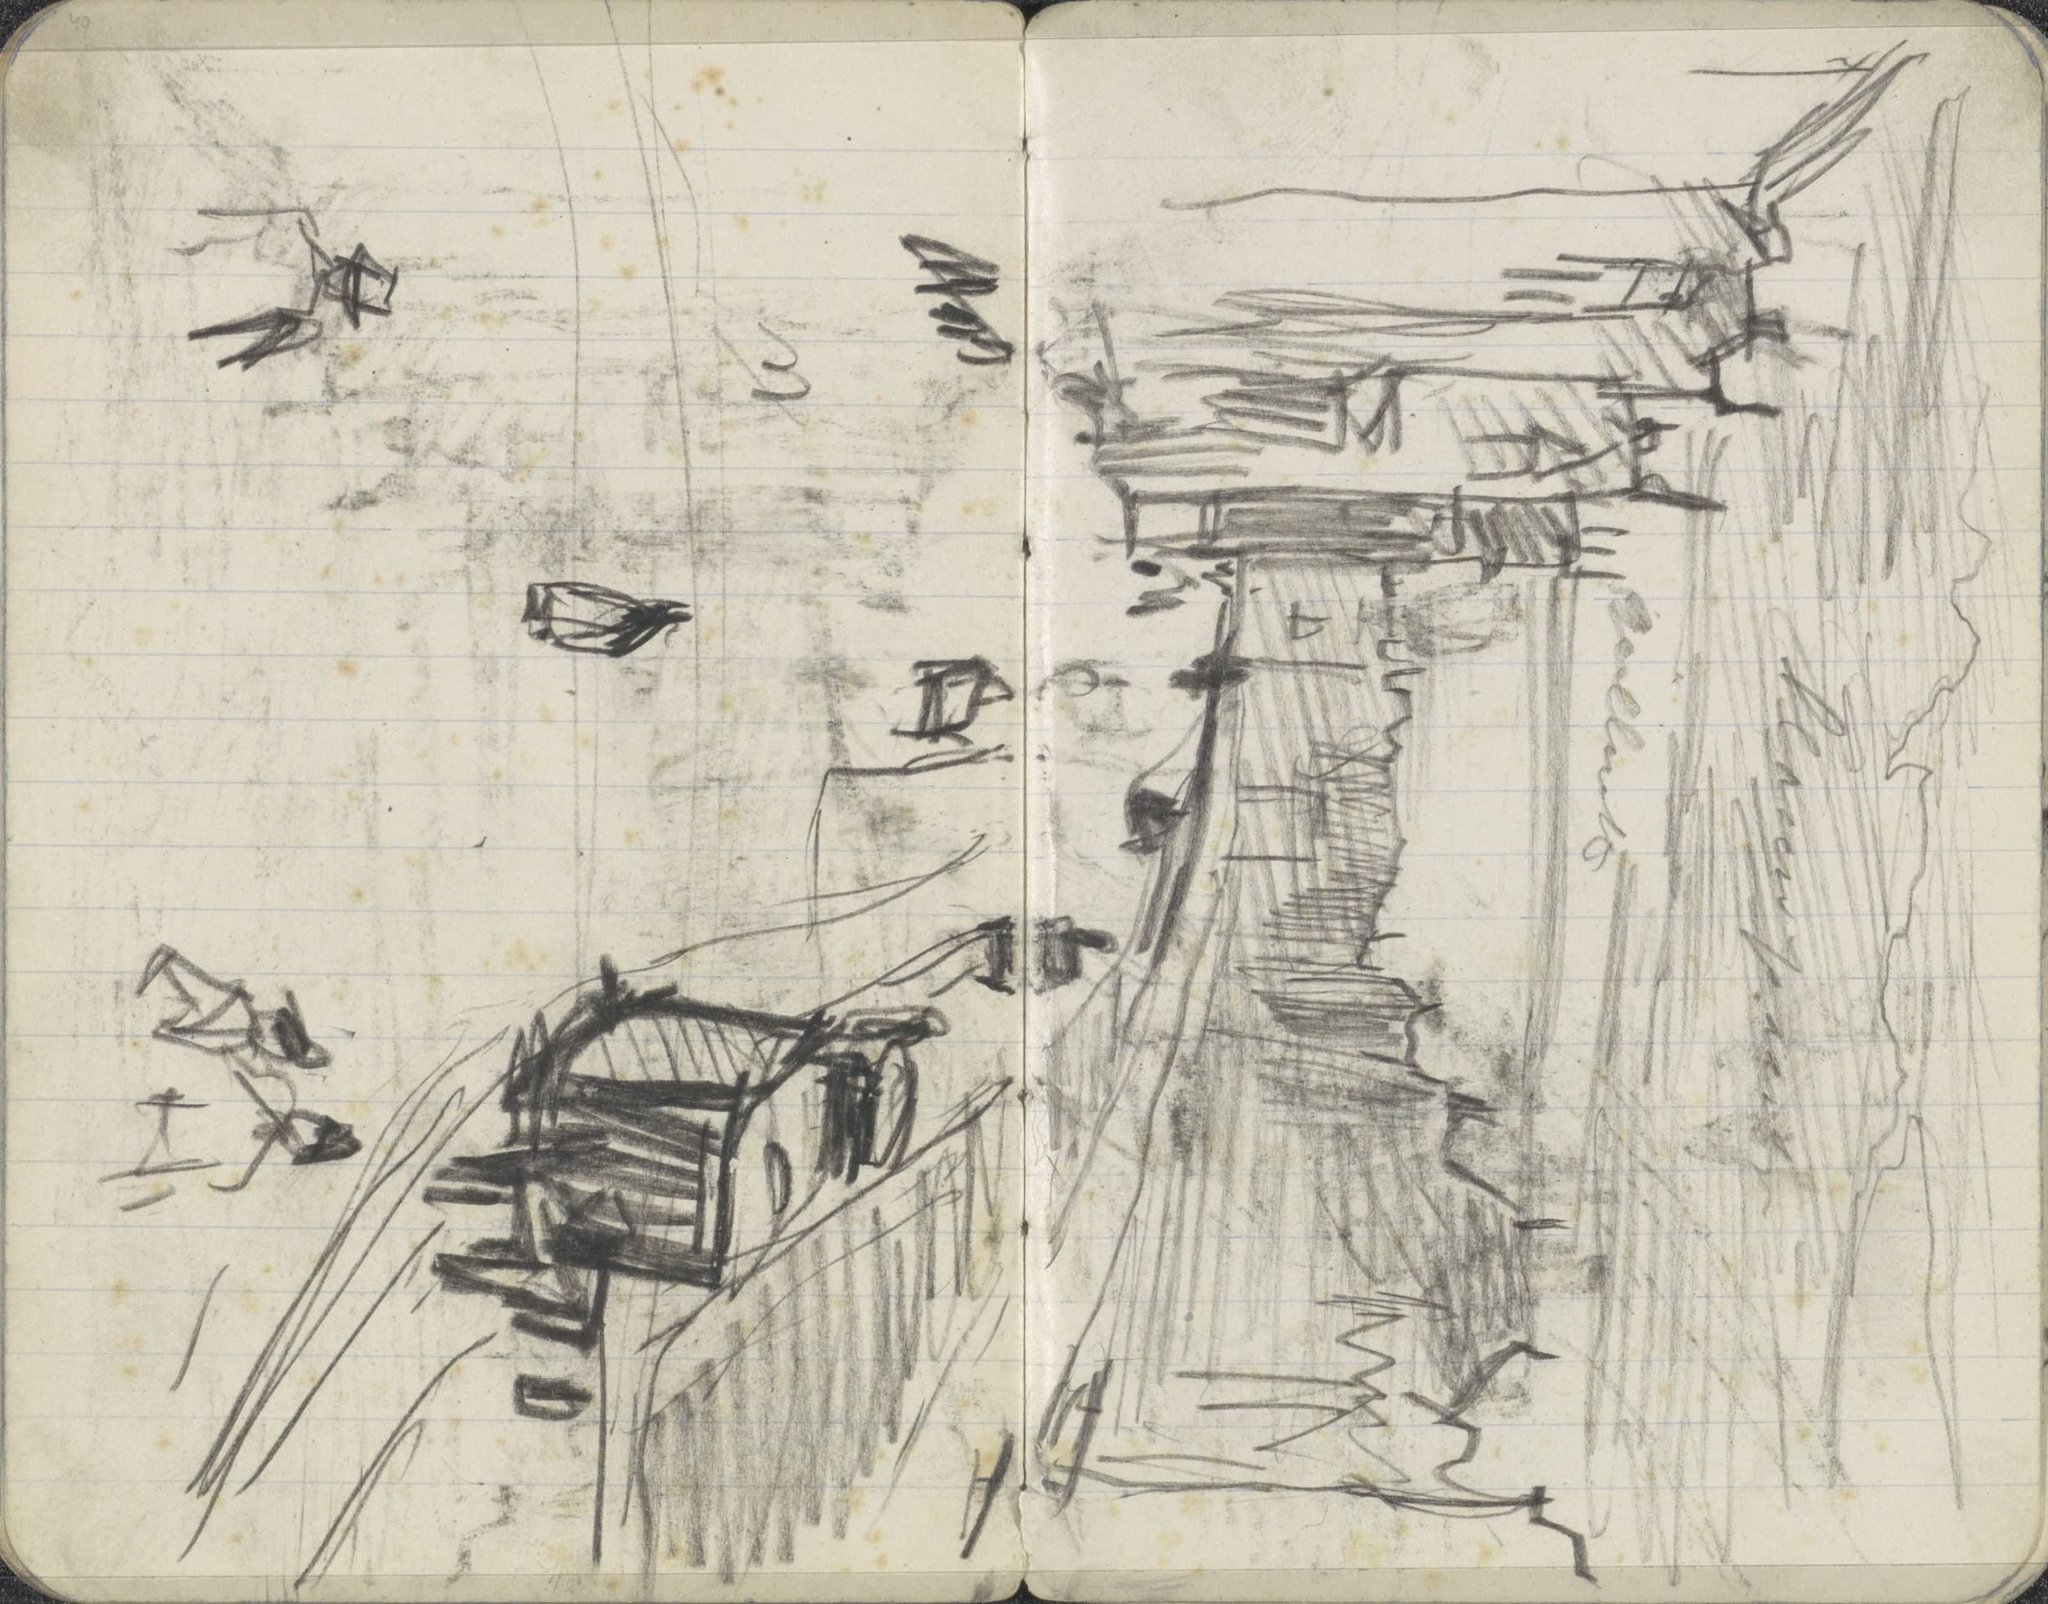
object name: sketchbook leaf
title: Gezicht op het Rokin te Amsterdam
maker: george hendrik breitner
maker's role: draughtsman, painter, print maker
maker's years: 1857-1923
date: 1896-1897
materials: chalk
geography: amsterdam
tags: diligence, omnibus, horse-tram, canals, waters (in city), civic architecture; edifices; dwellings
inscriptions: kleurnotitie, handgeschreven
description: Gezien vanuit Rokin 112, kunstenaarsvereniging Arti et Amicitiae. Vooraan een paardentram. Pagina 49 en pagina 50 uit een schetsboek met 39 bladen.